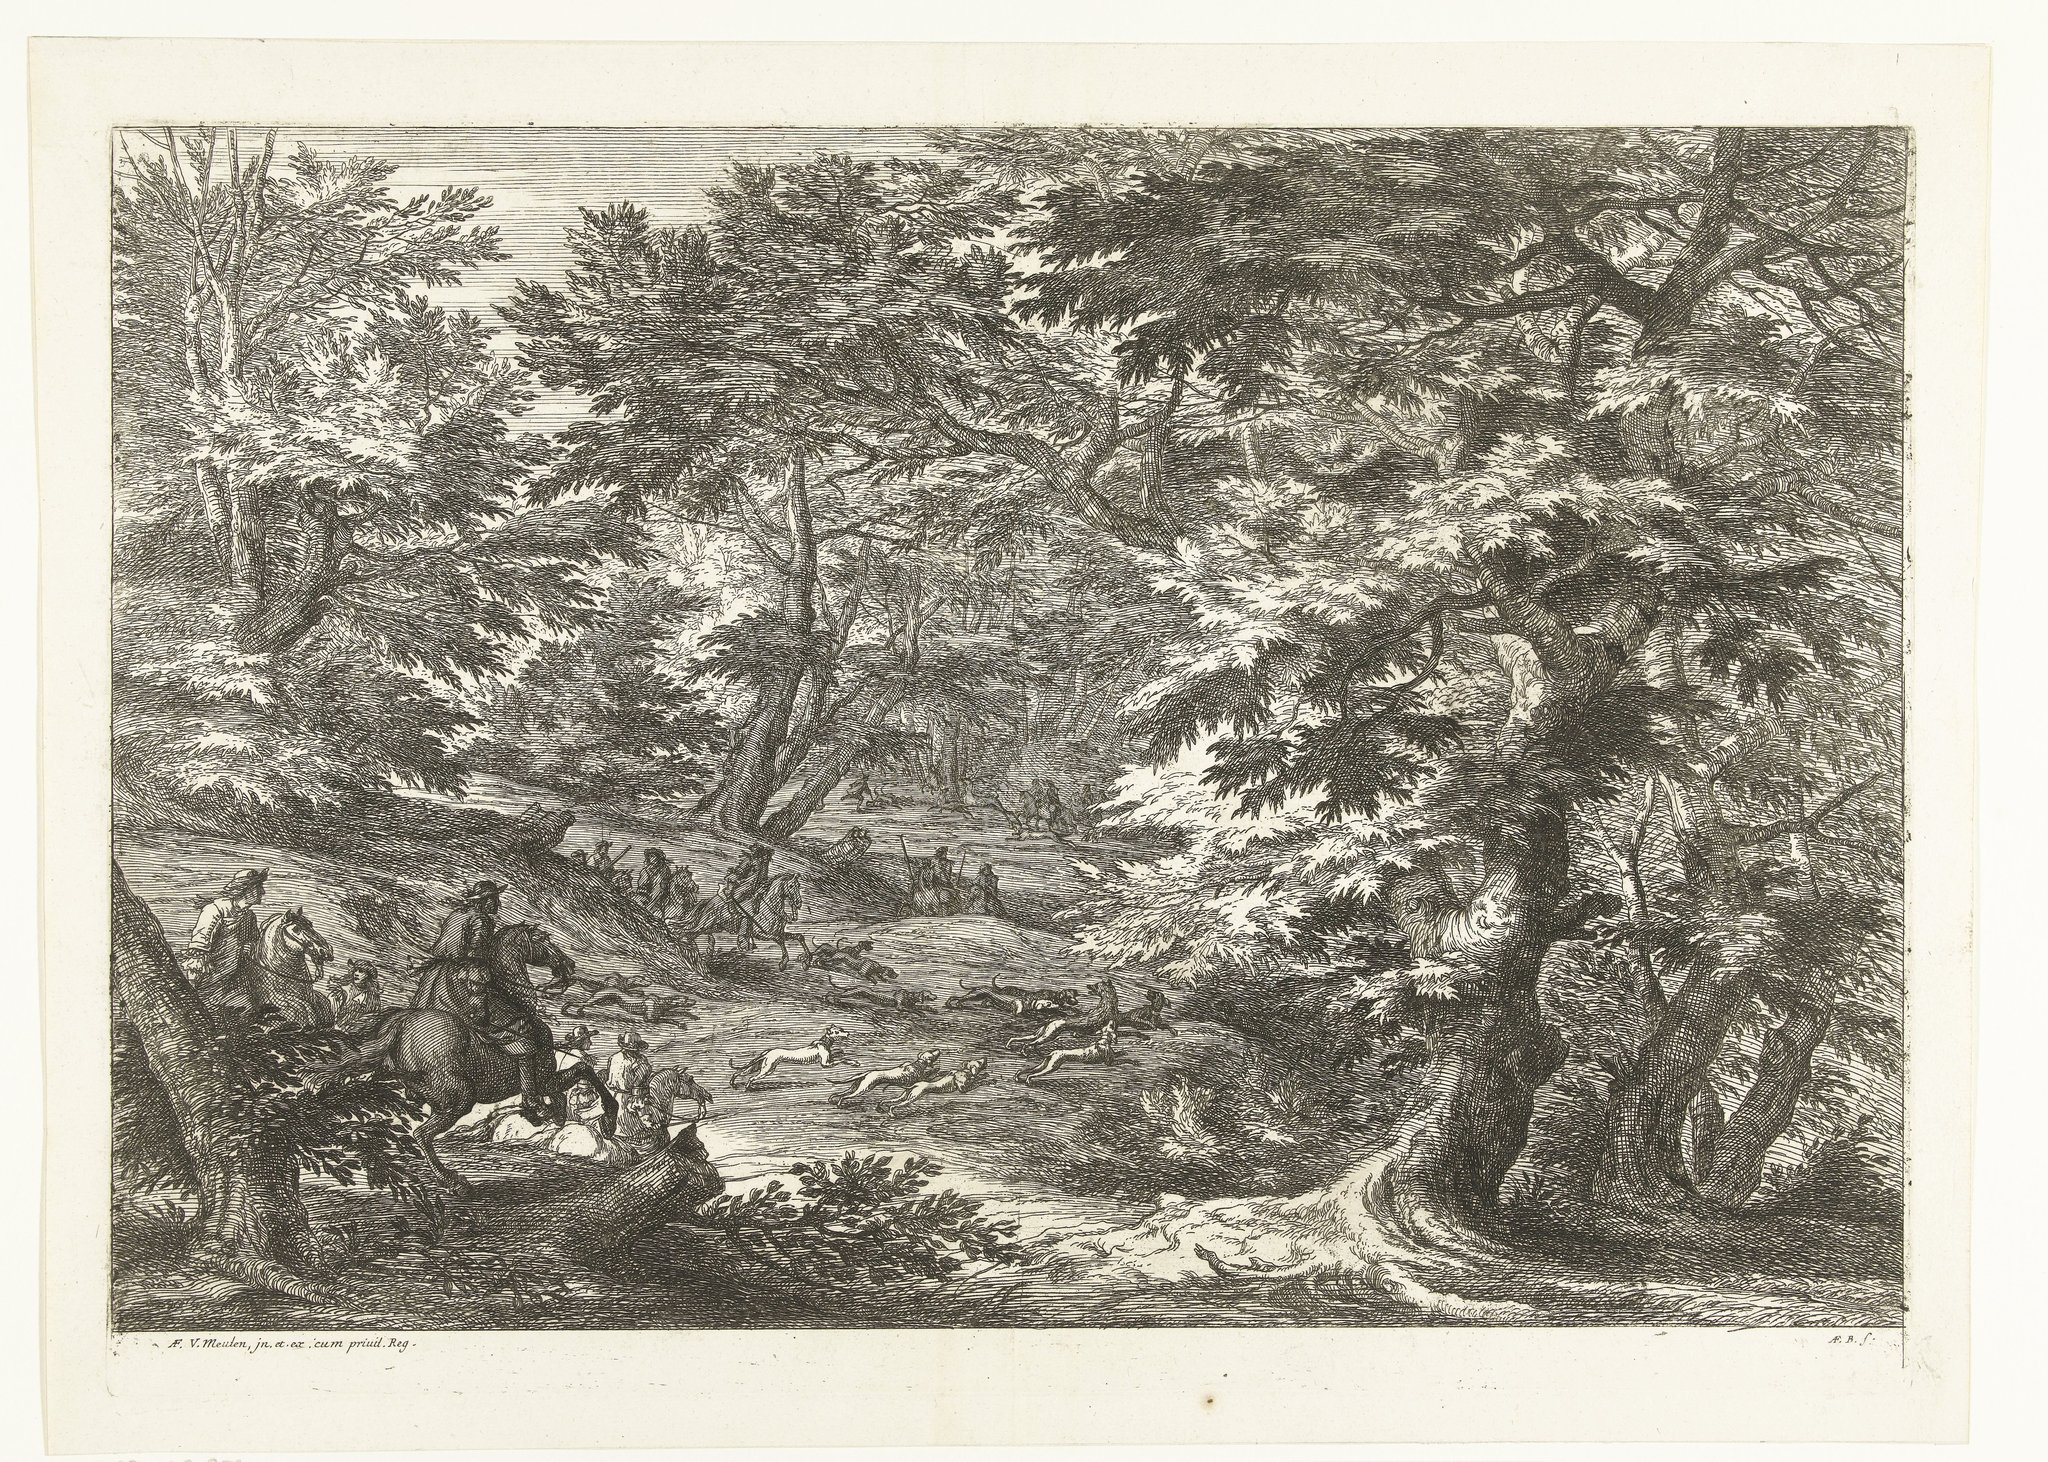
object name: print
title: Landschap met vossejacht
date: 1666-1681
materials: paper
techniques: etching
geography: paris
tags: hunting, chase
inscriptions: collector's mark: Lugt 2228